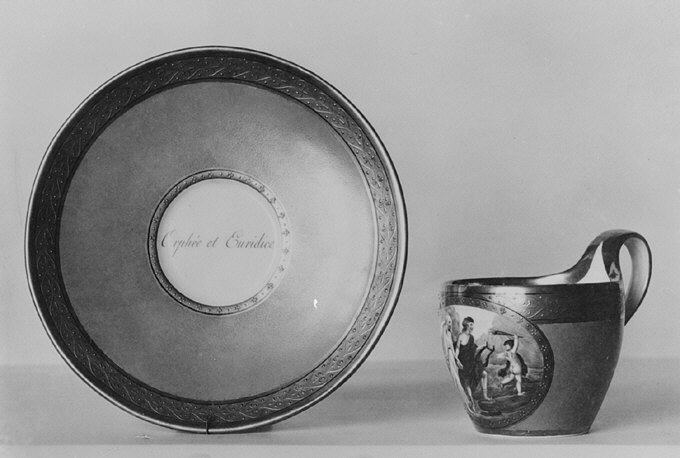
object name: cup and saucer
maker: royal porcelain manufactory, berlin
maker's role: manufactory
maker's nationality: german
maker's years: 1763-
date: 1803-1810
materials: hard paste porcelain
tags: orpheus,eurydice